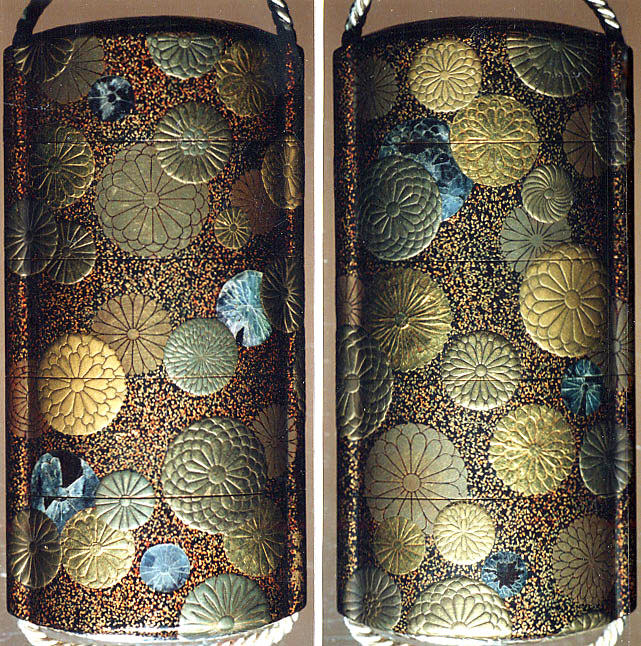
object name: inrō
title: Case (Inrō) with Design of Scattered Chrysanthemums (Kikumon)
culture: japanese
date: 1801-1900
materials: gold, gold foil, lacquer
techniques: fundame, hiramakie, roiro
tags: flowers